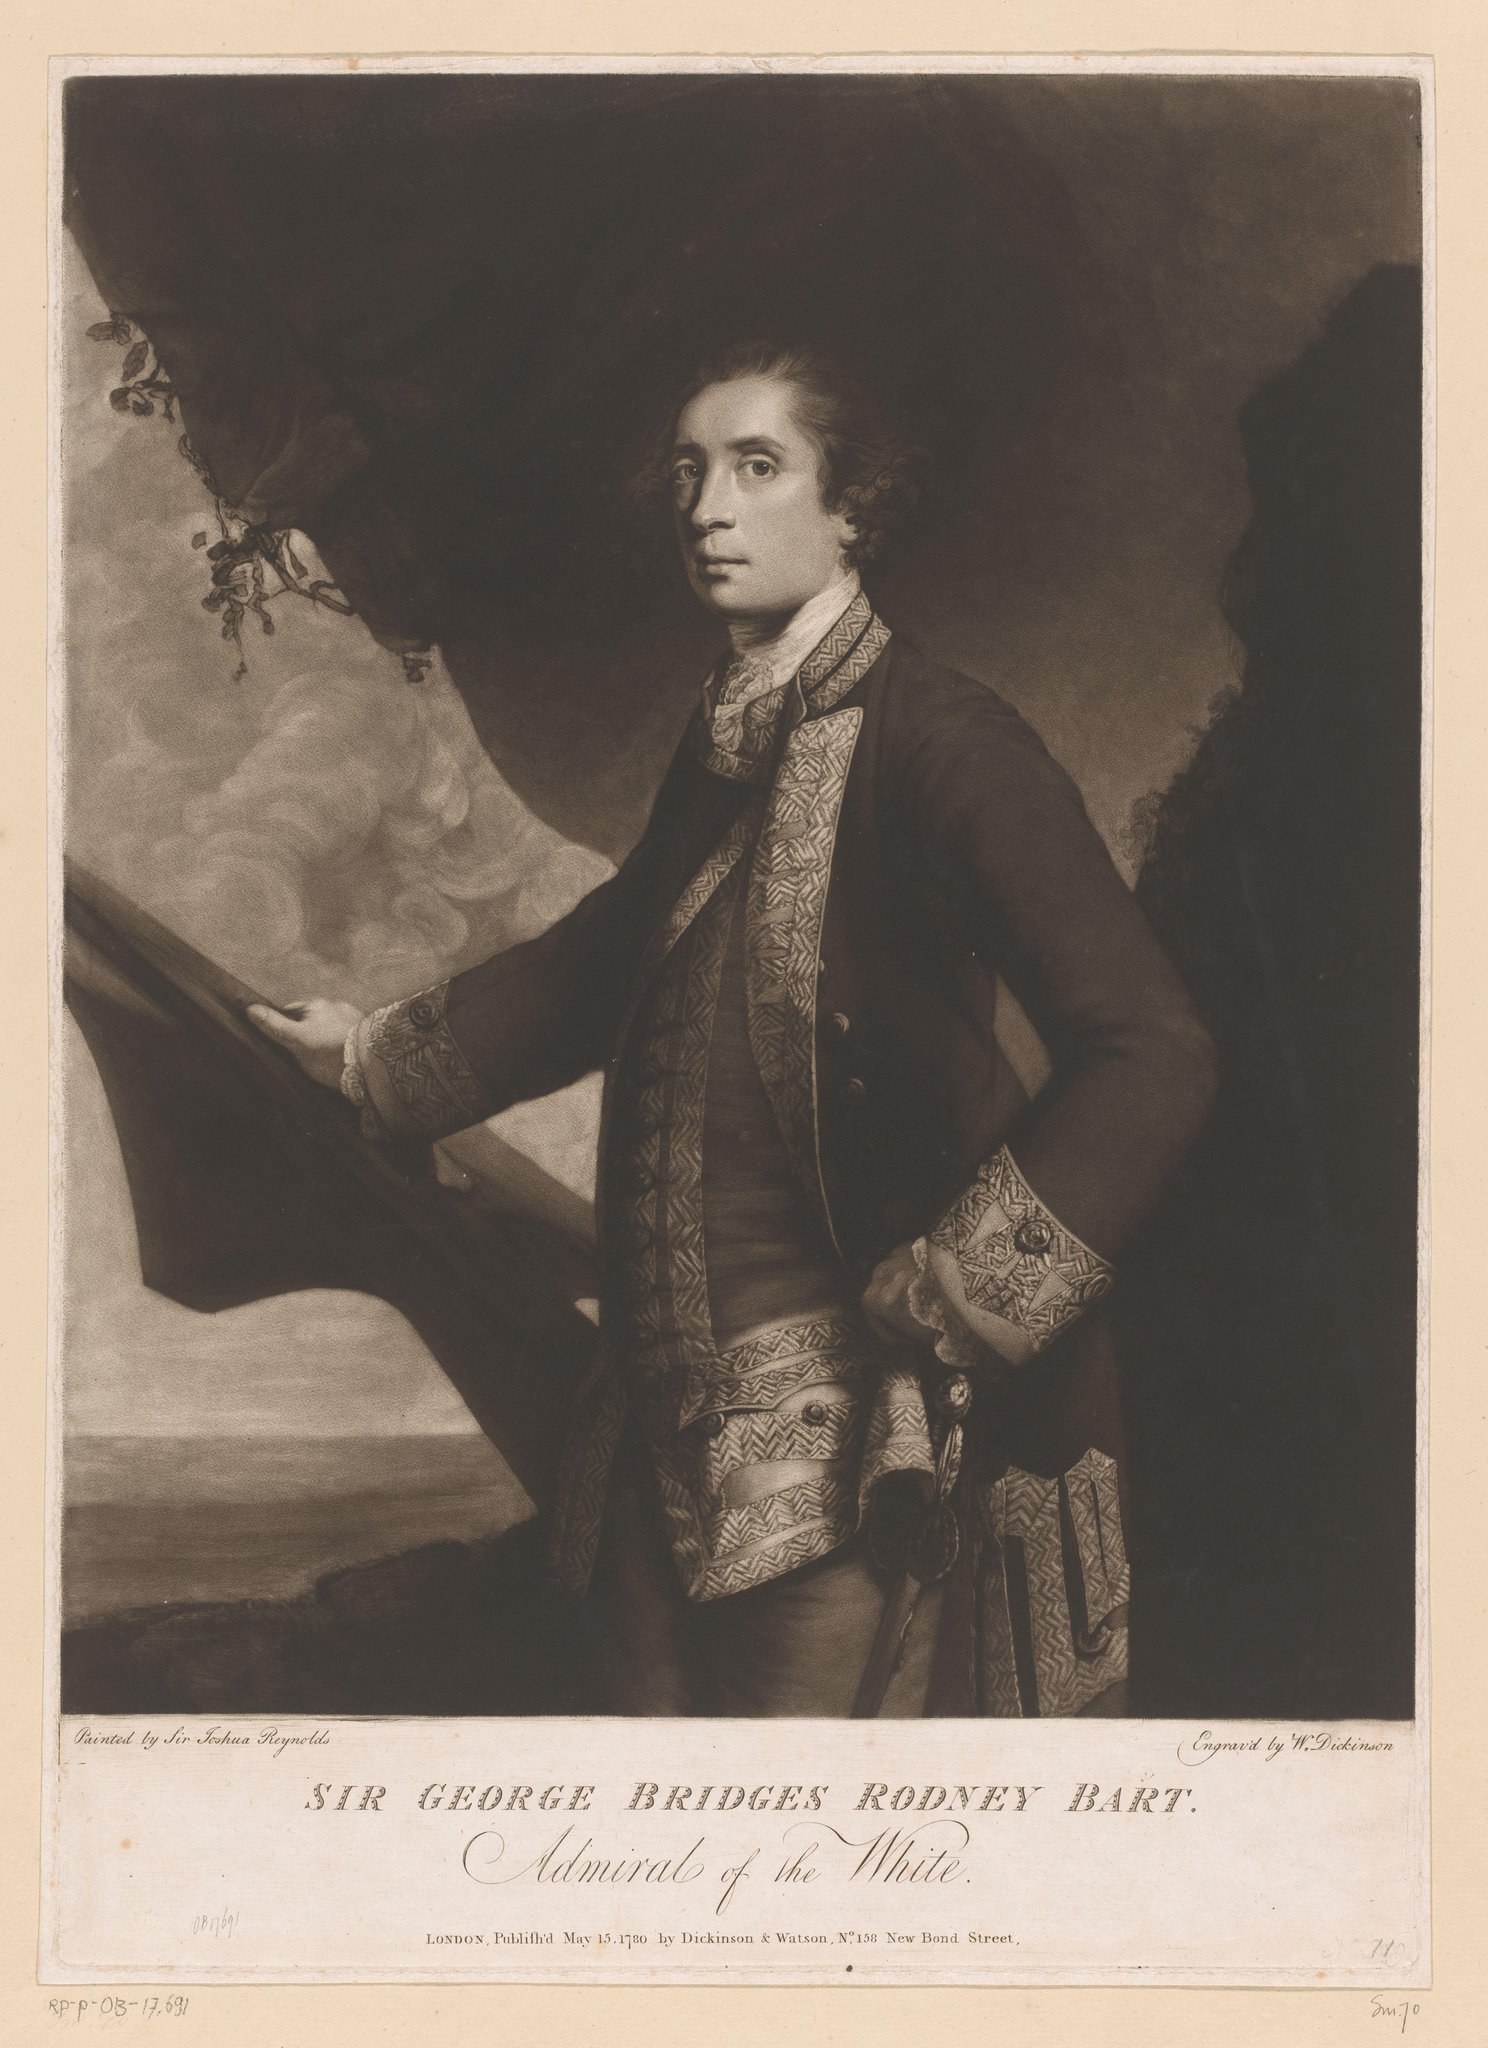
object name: print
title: Portret van George Brydges Rodney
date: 1780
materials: paper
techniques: mezzotint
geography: london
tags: historical persons, commander-in-chief, admiral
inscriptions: collector's mark: Lugt 240